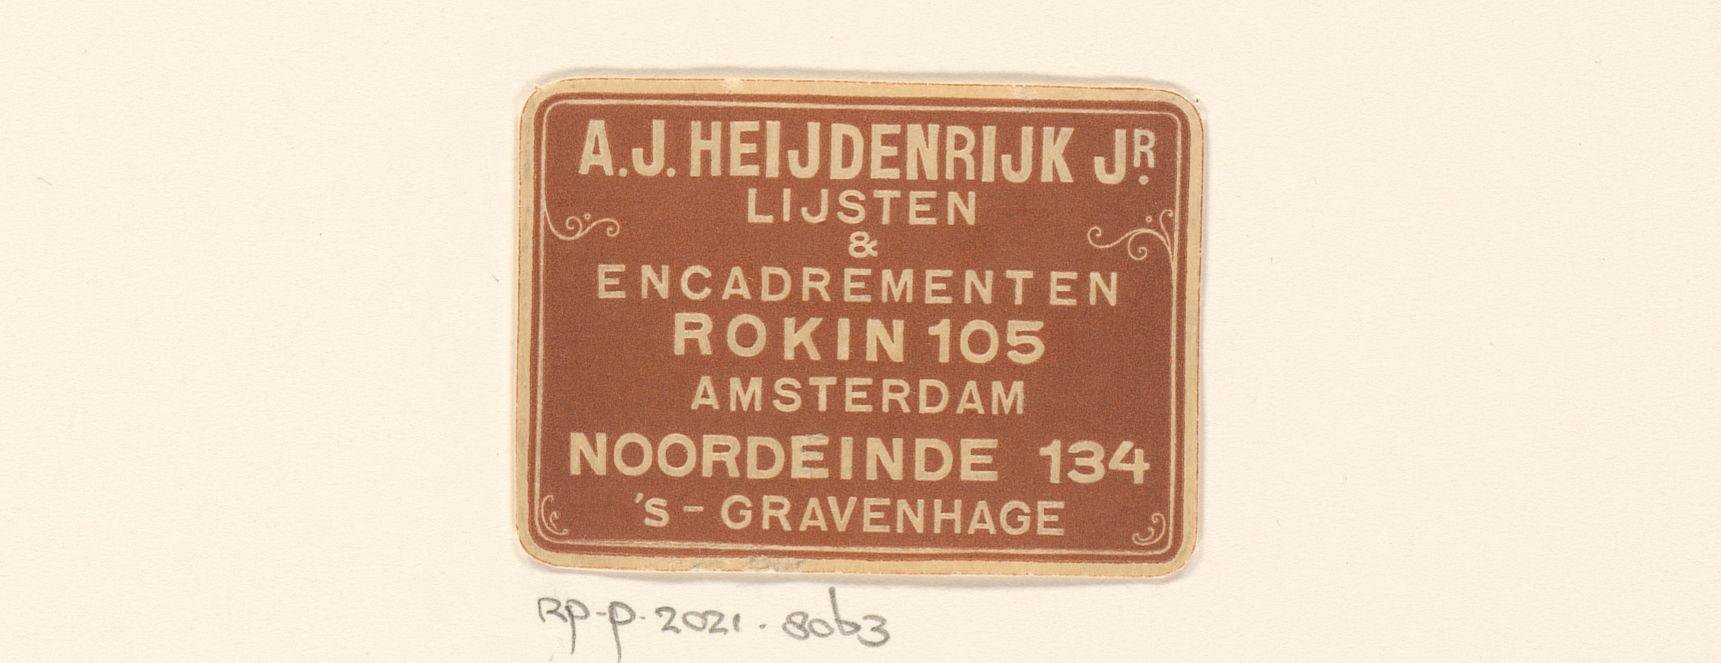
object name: label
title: Etiket van lijstenmaker A.J. Heijdenrijk Jr.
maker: Anonymous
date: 1845-1940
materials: paper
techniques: blind stamped, printing block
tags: printed matter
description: Bij gebrek aan gegevens over de vervaardiger is voor de bepaling van de rechten van dit object gebruik gemaakt van de (geschatte) vervaardigingsdatum.